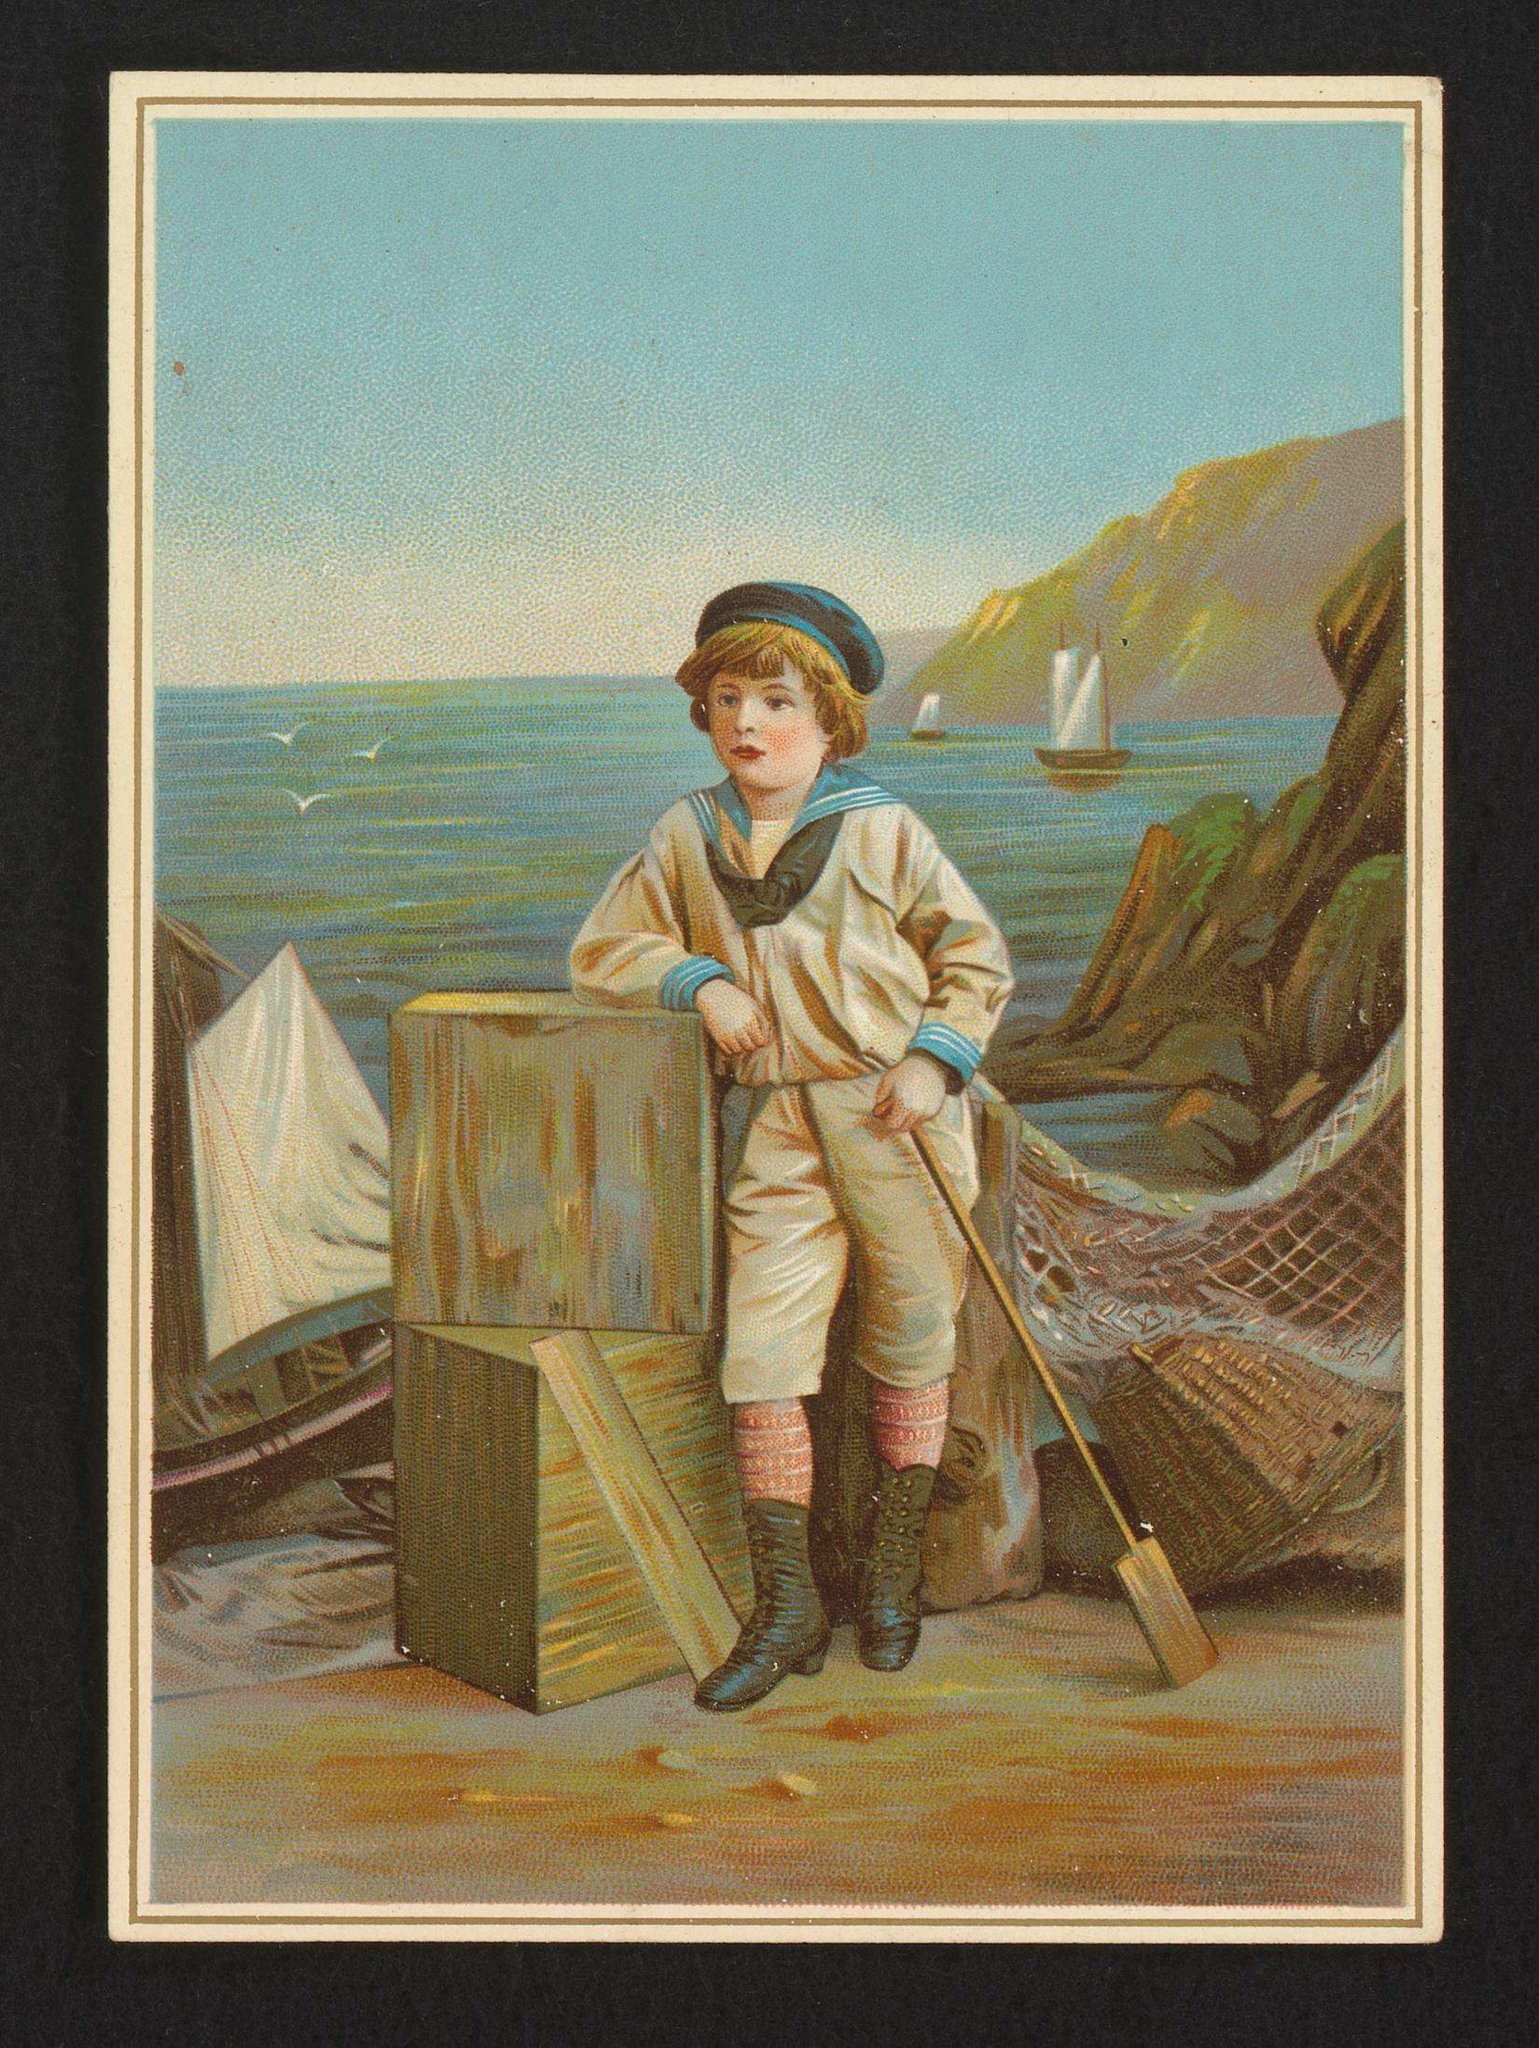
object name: print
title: Portret van een jongen in matrozenpak, staand op een kade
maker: Anonymous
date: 1880-1920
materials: cardboard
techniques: chromolithography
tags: ensemble of pieces of clothing: sailor suit, boy (child between toddler and youth), historical persons, quay